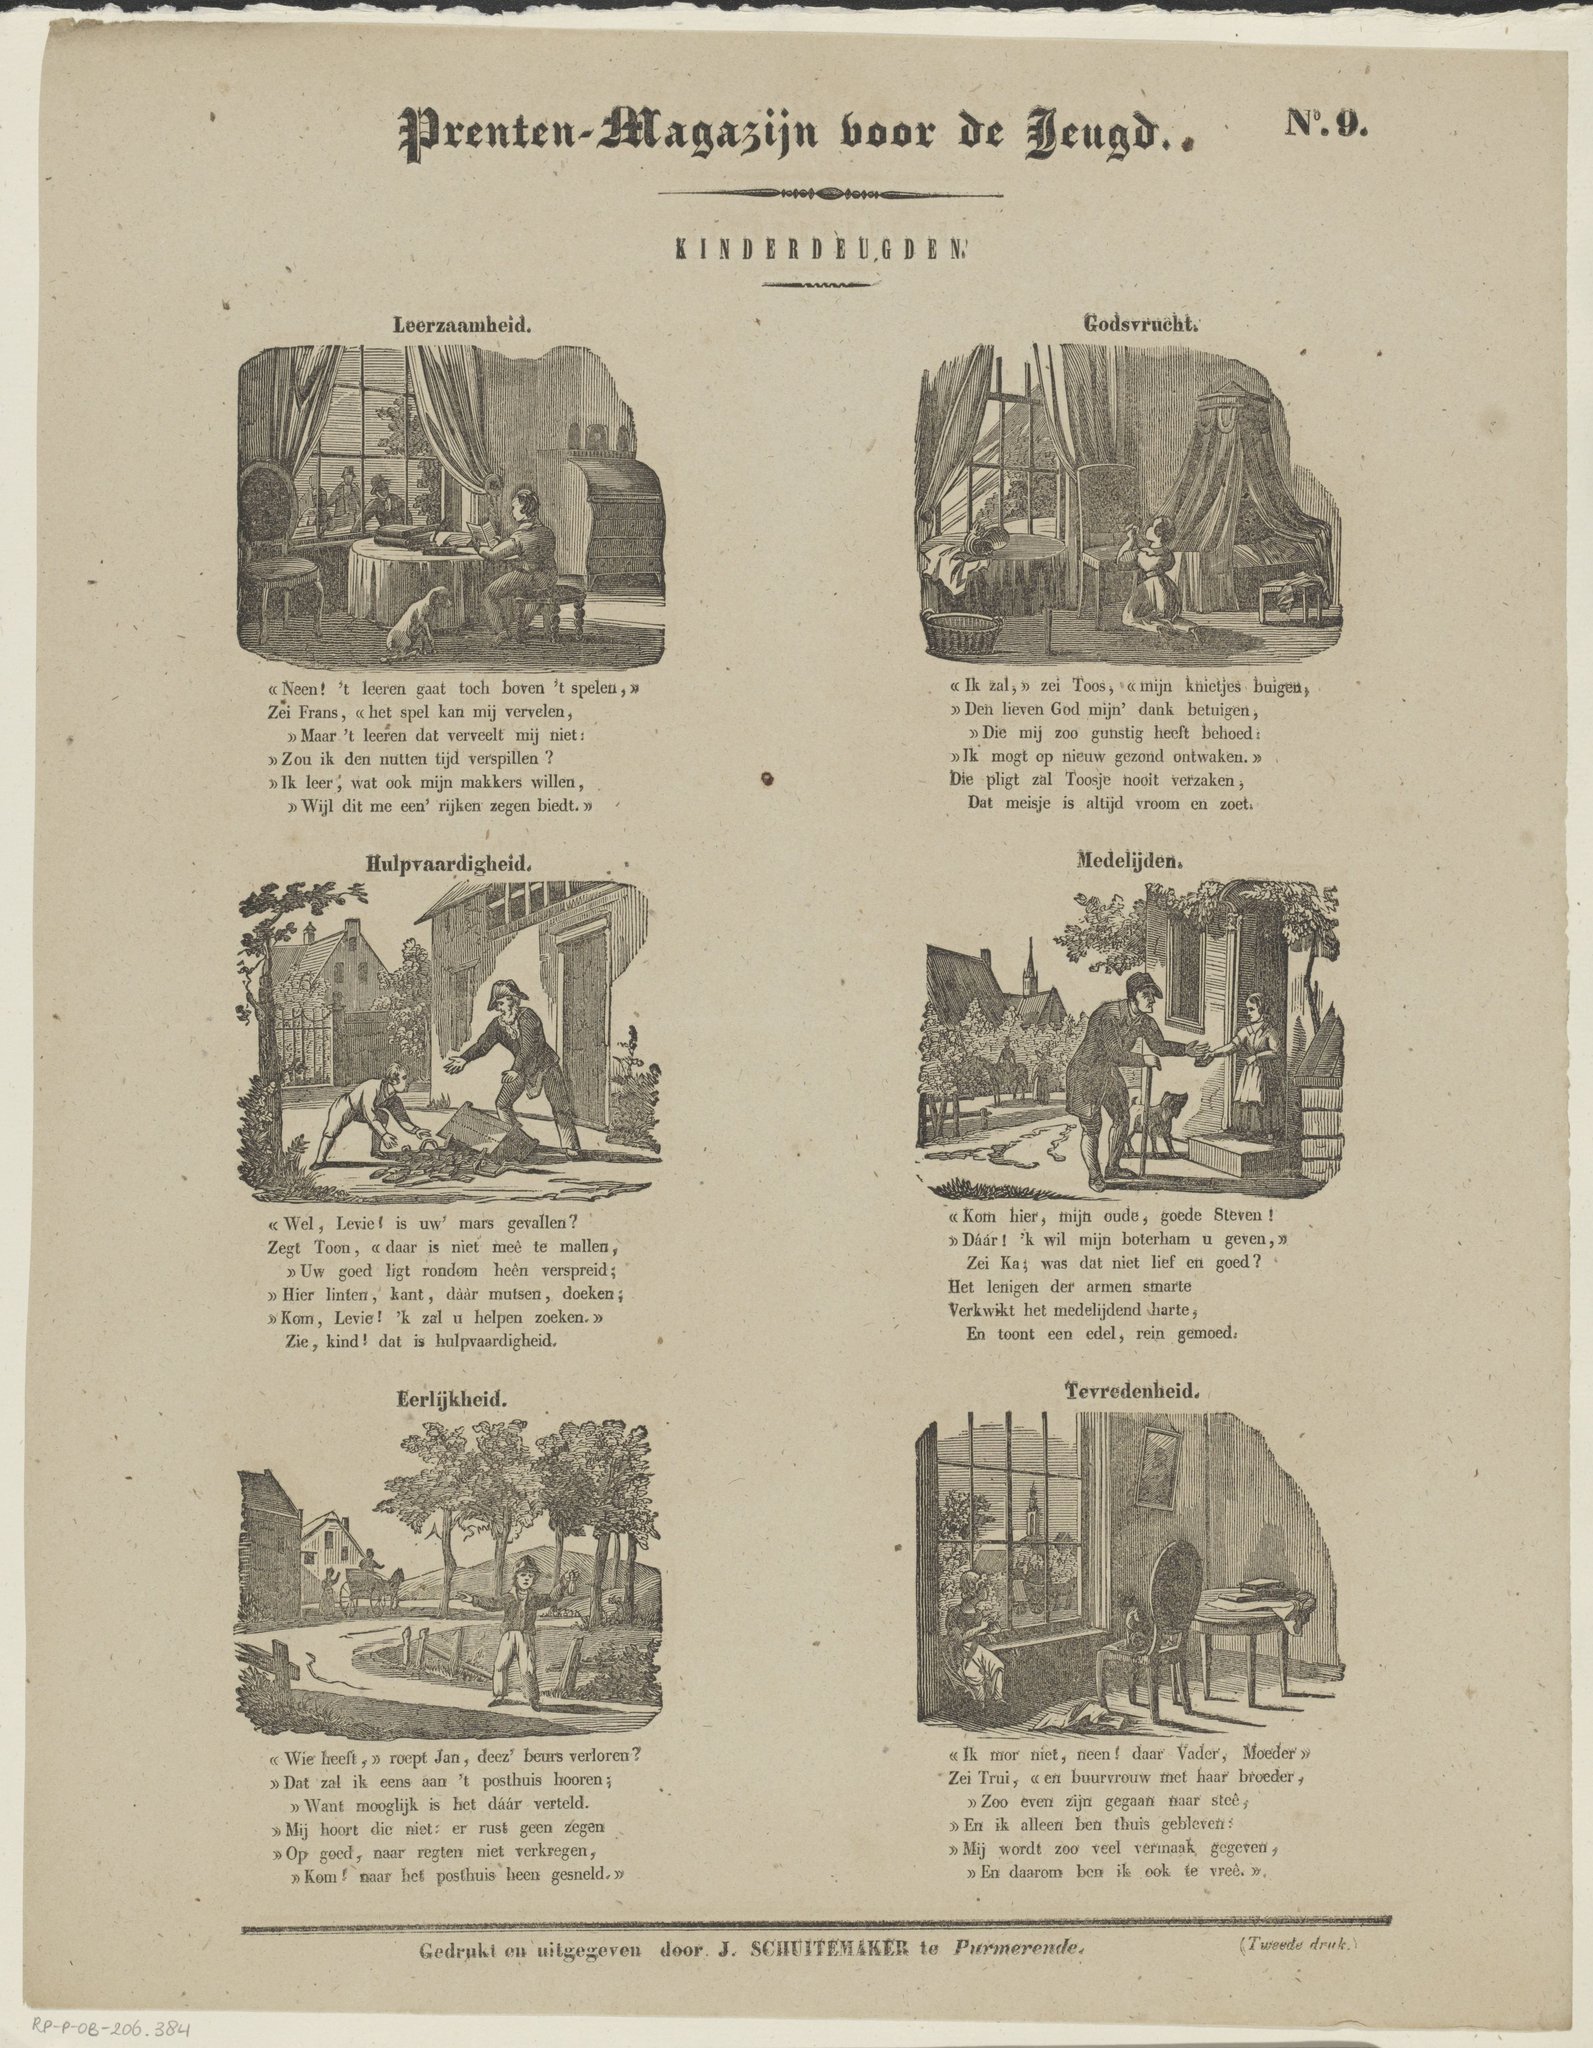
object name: popular print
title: Kinderdeugden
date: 1842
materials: paper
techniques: letterpress printing, engraving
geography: purmerend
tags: godliness ~ the three theological virtues, satisfaction, contentment; 'contento' (ripa), helpfulness, docility; 'docilità' (ripa), honesty; 'honestà' (ripa), mercy, compassion; 'compassione', 'misericordia' (ripa)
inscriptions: collector's mark: Lugt 2760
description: Blad met 6 voorstellingen van kinderdeugden, zoals leerzaamheid, godsvrucht en hulpvaardigheid. Boven elke voorstelling een titel en onder elke voorstelling een zesregelig vers. Genummerd rechtsboven: No. 9.